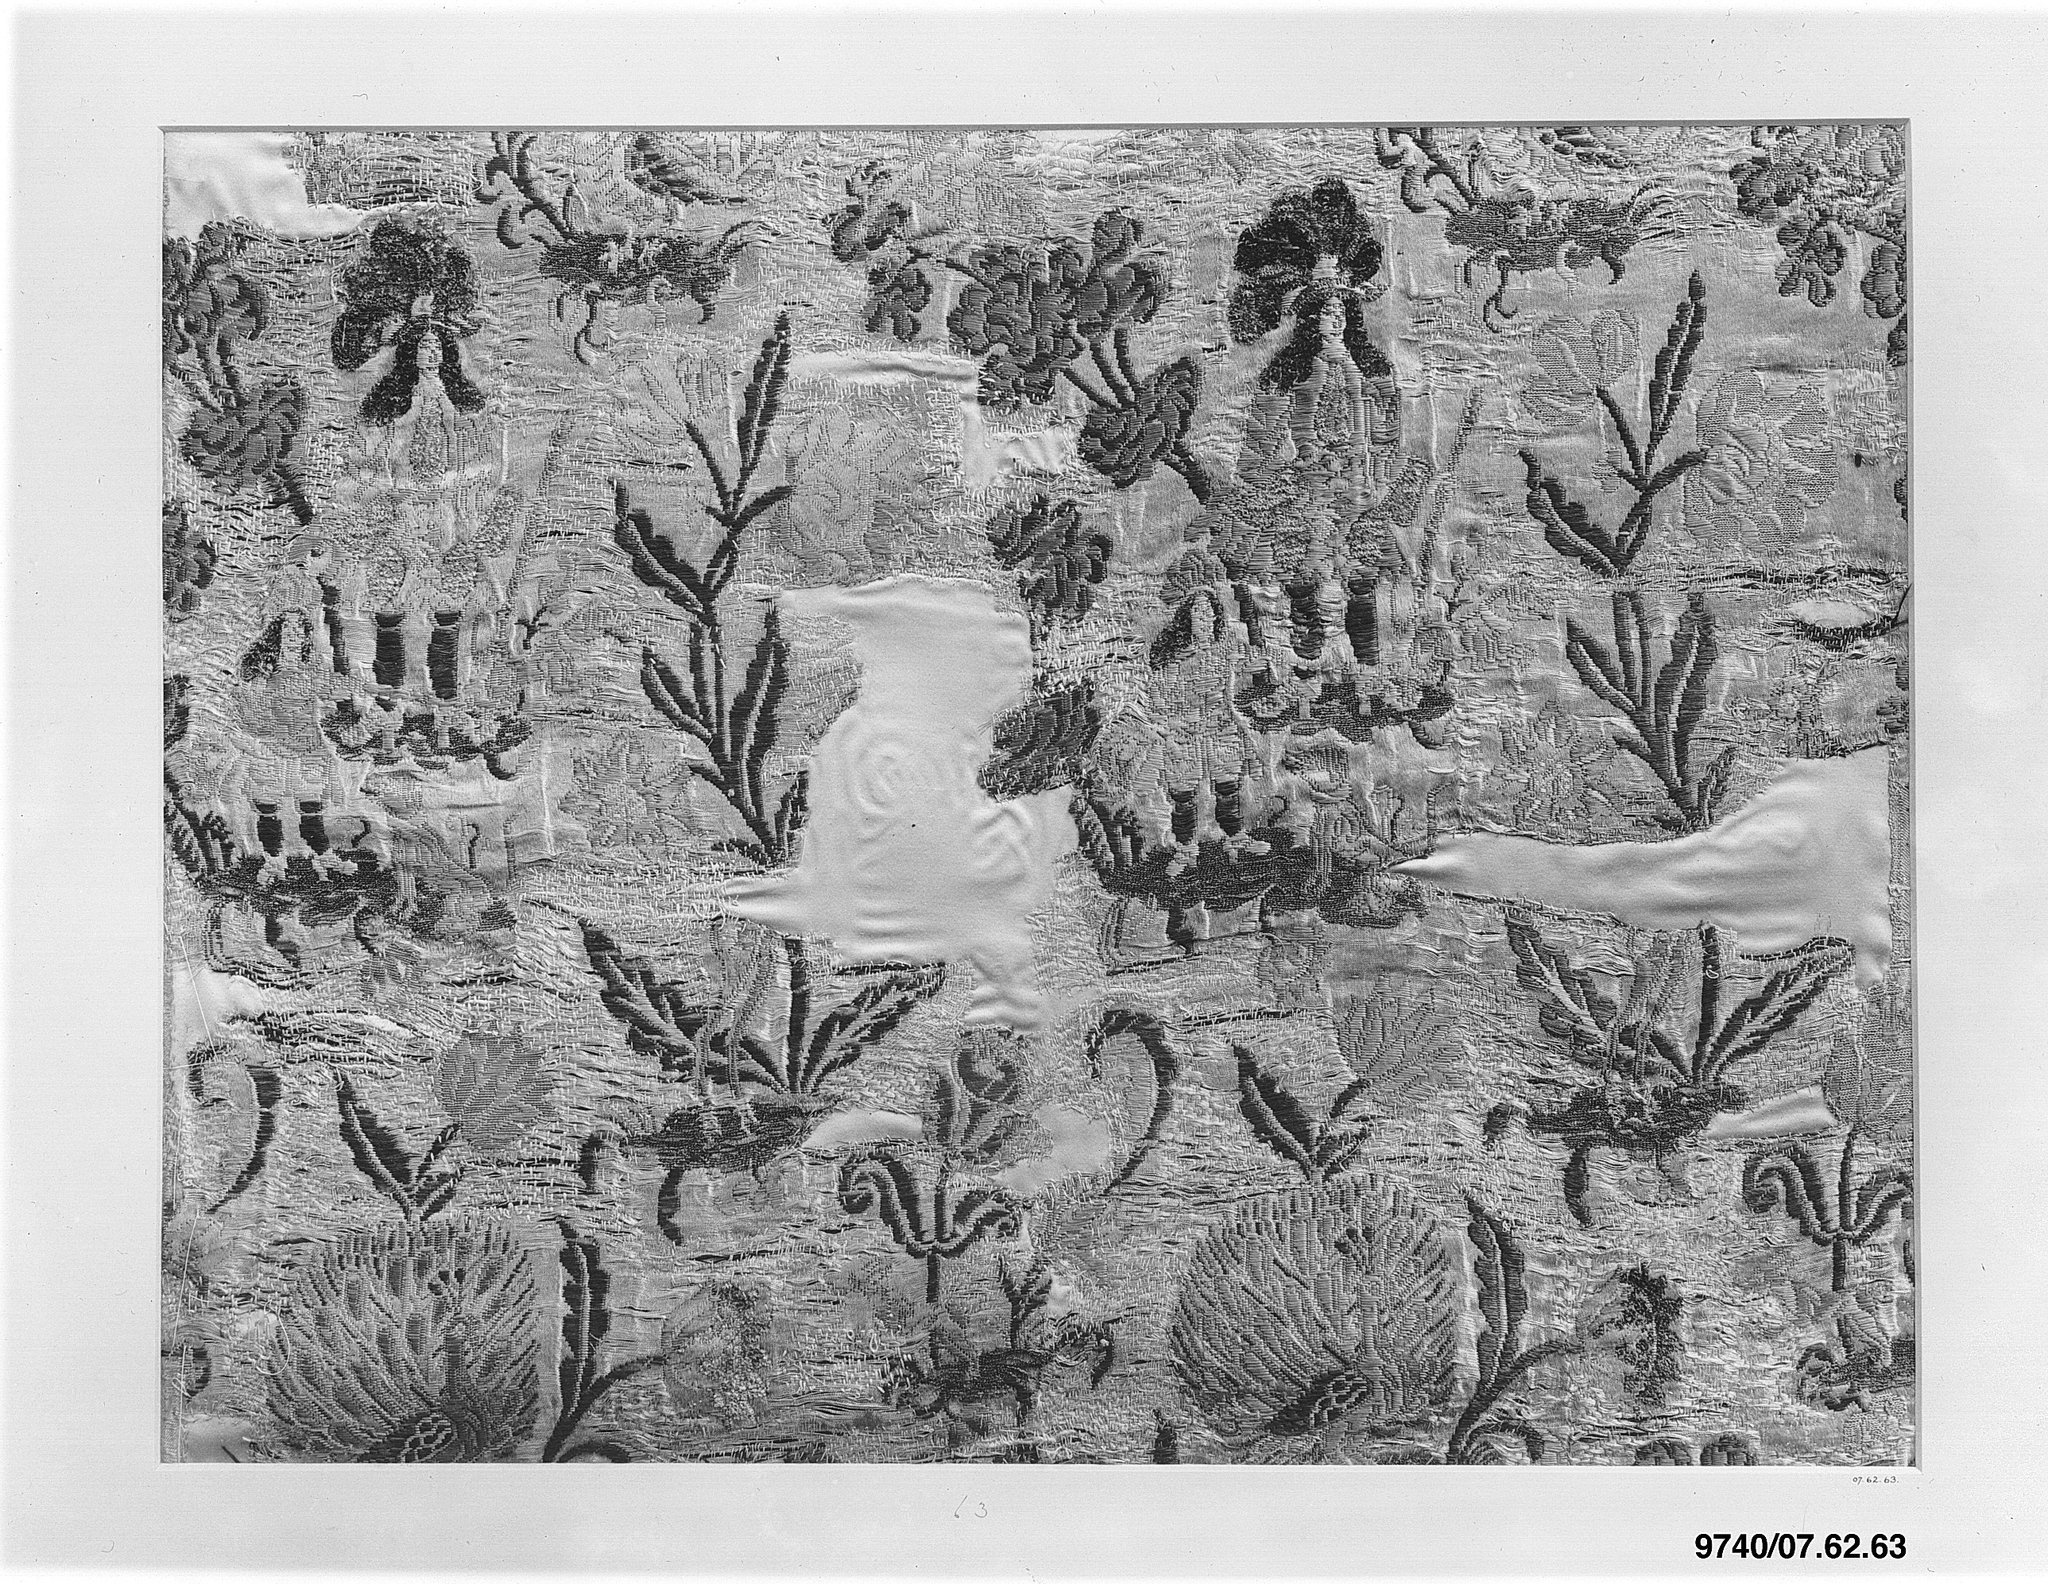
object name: piece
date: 1601-1800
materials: silk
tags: human figures,peacocks,flowers,leaves